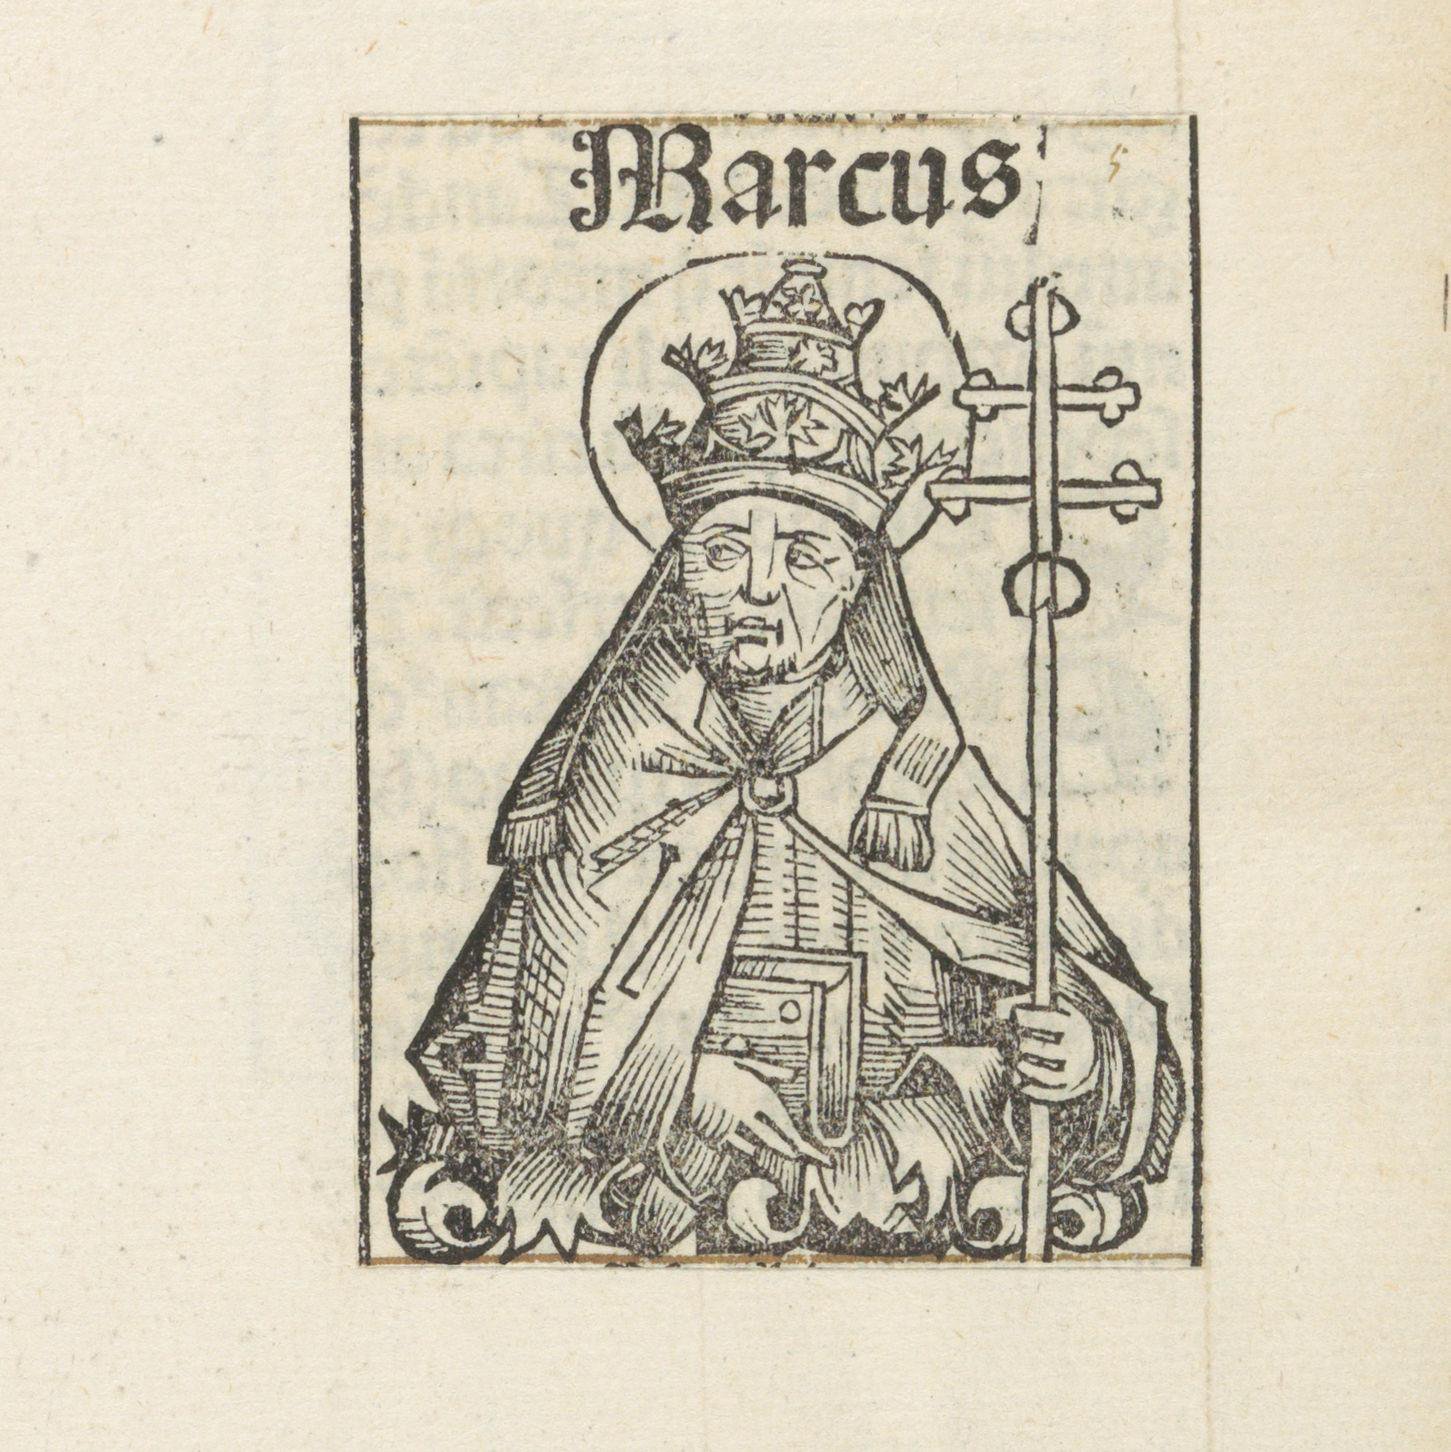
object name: print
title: Liber Chronicarum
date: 1493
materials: paper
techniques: letterpress printing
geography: nuremberg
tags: rome, pope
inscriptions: inscription: ‘5’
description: Een bloemkelk met een paus. Hij draagt een tiara en heeft een bijbel en staf met een dubbel kruis in zijn handen. De nimbus om zijn hoofd vertelt dat deze paus heilig is verklaard. De voorstelling is onderdeel van de opeenvolging pausen in de Liber Chronicarum. De tekst identificeert de man als paus Marcus. De prent maakt deel uit van een album.